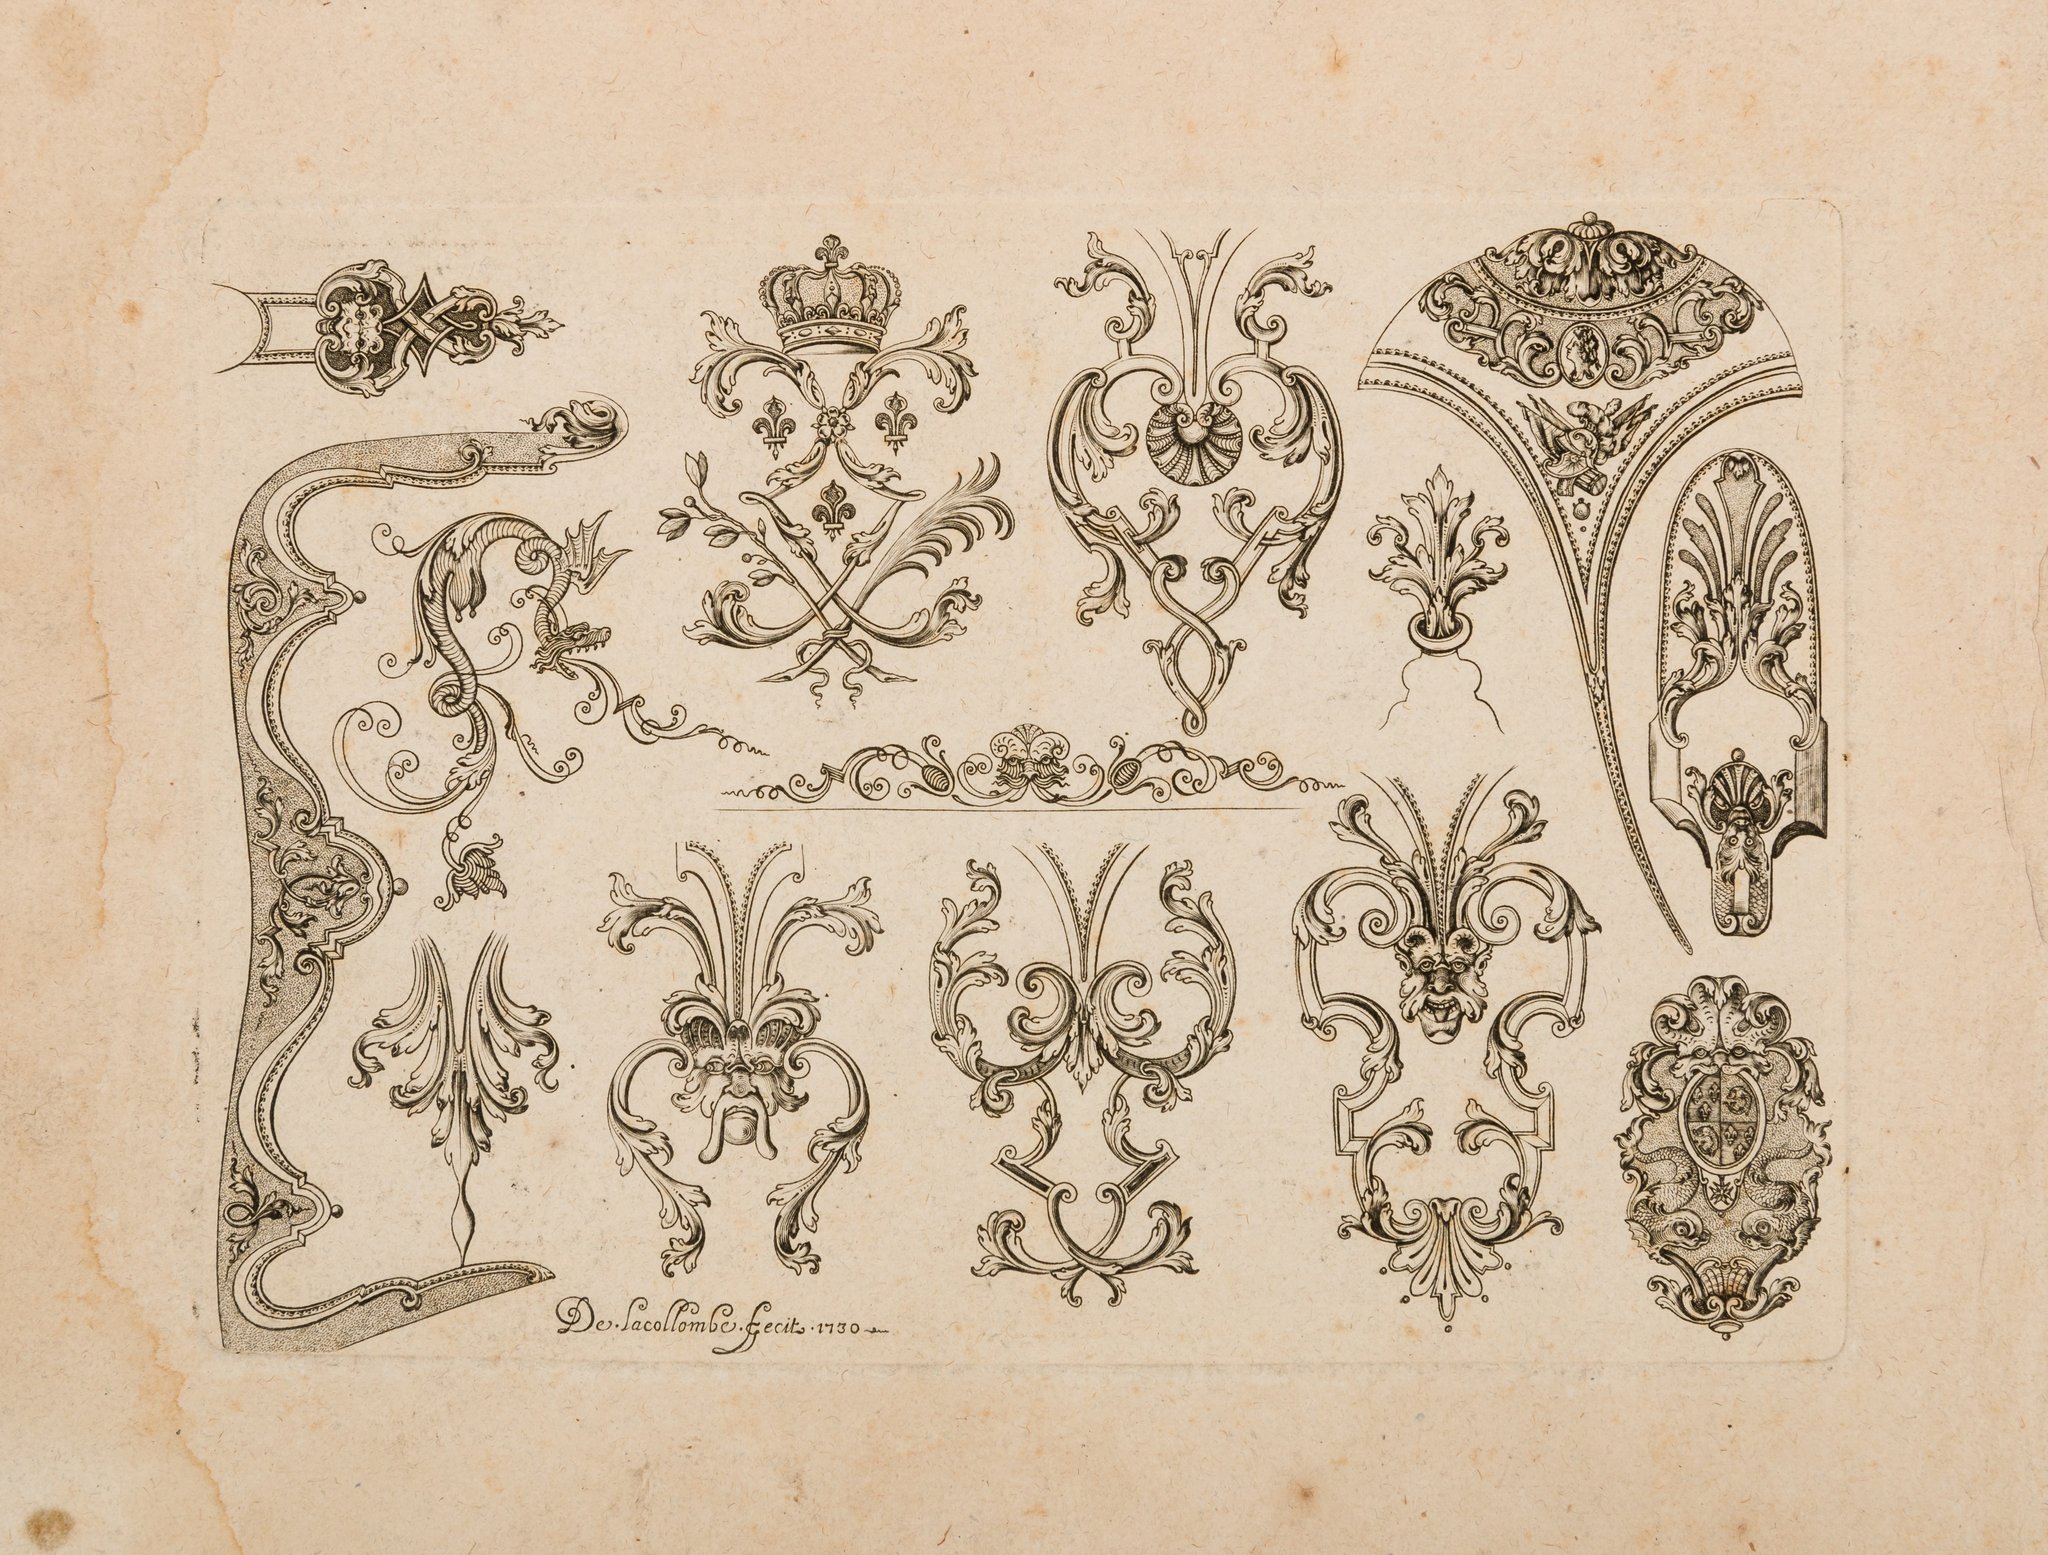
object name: engraving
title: Plate Two from Nouveavx Desseins D'Arquebvseries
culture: french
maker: de lacollombe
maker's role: engraver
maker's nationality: french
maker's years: 1702-1736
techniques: engraving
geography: france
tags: ornament